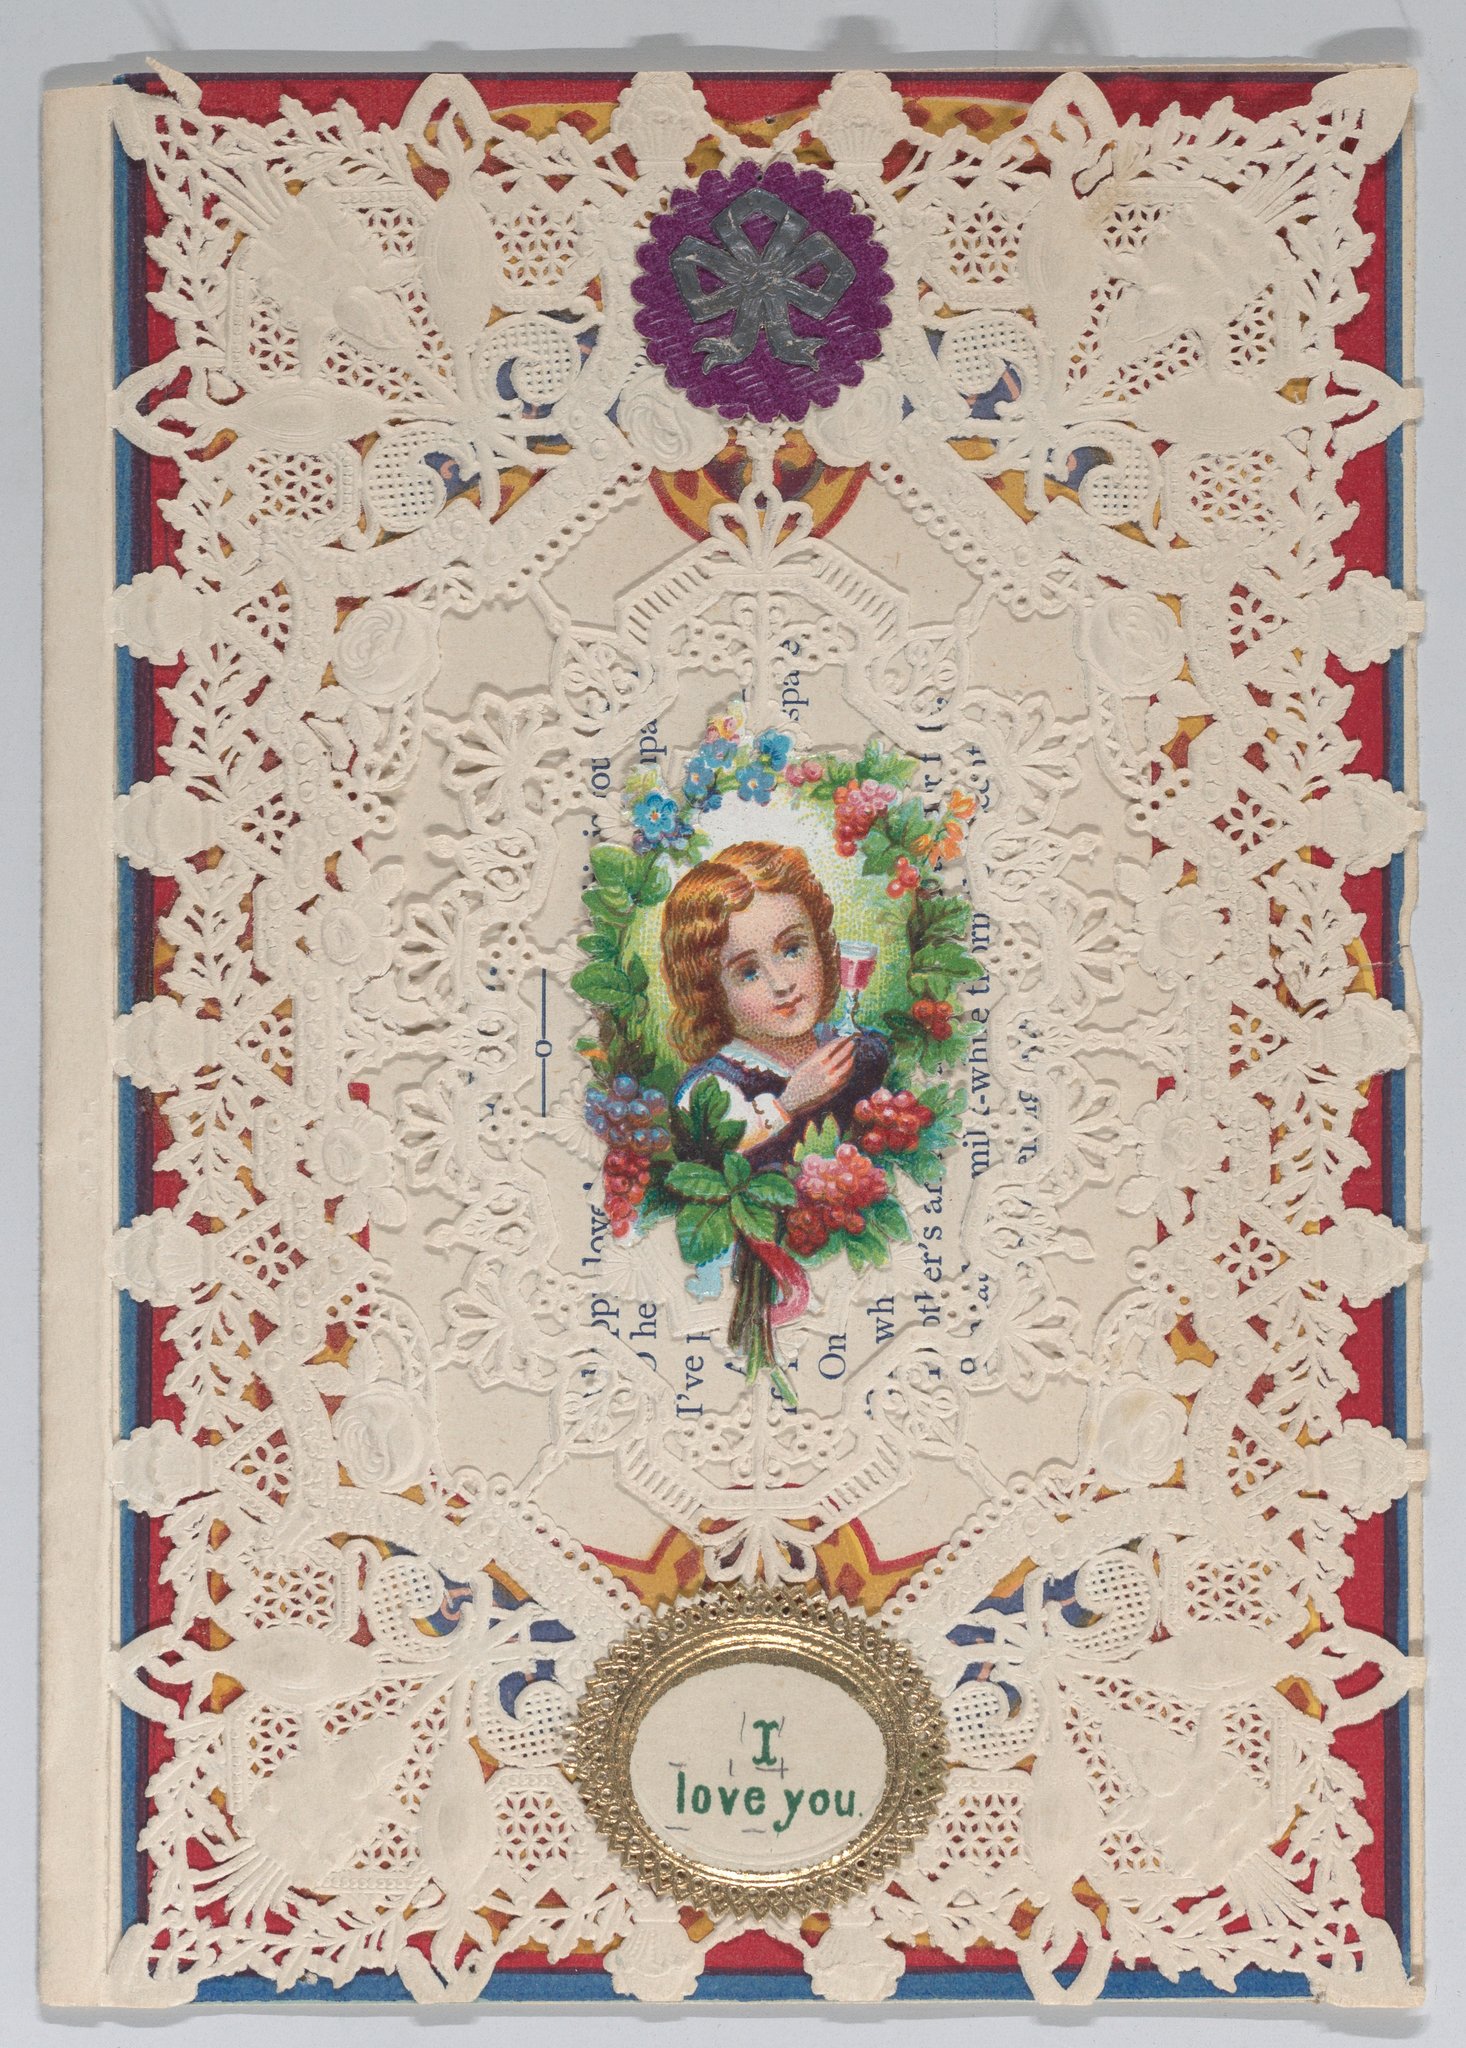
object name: valentine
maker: Anonymous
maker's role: artist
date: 1880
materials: graphite, lace, paper, silver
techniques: chromolithography, cutting, embossing, gilding, open work